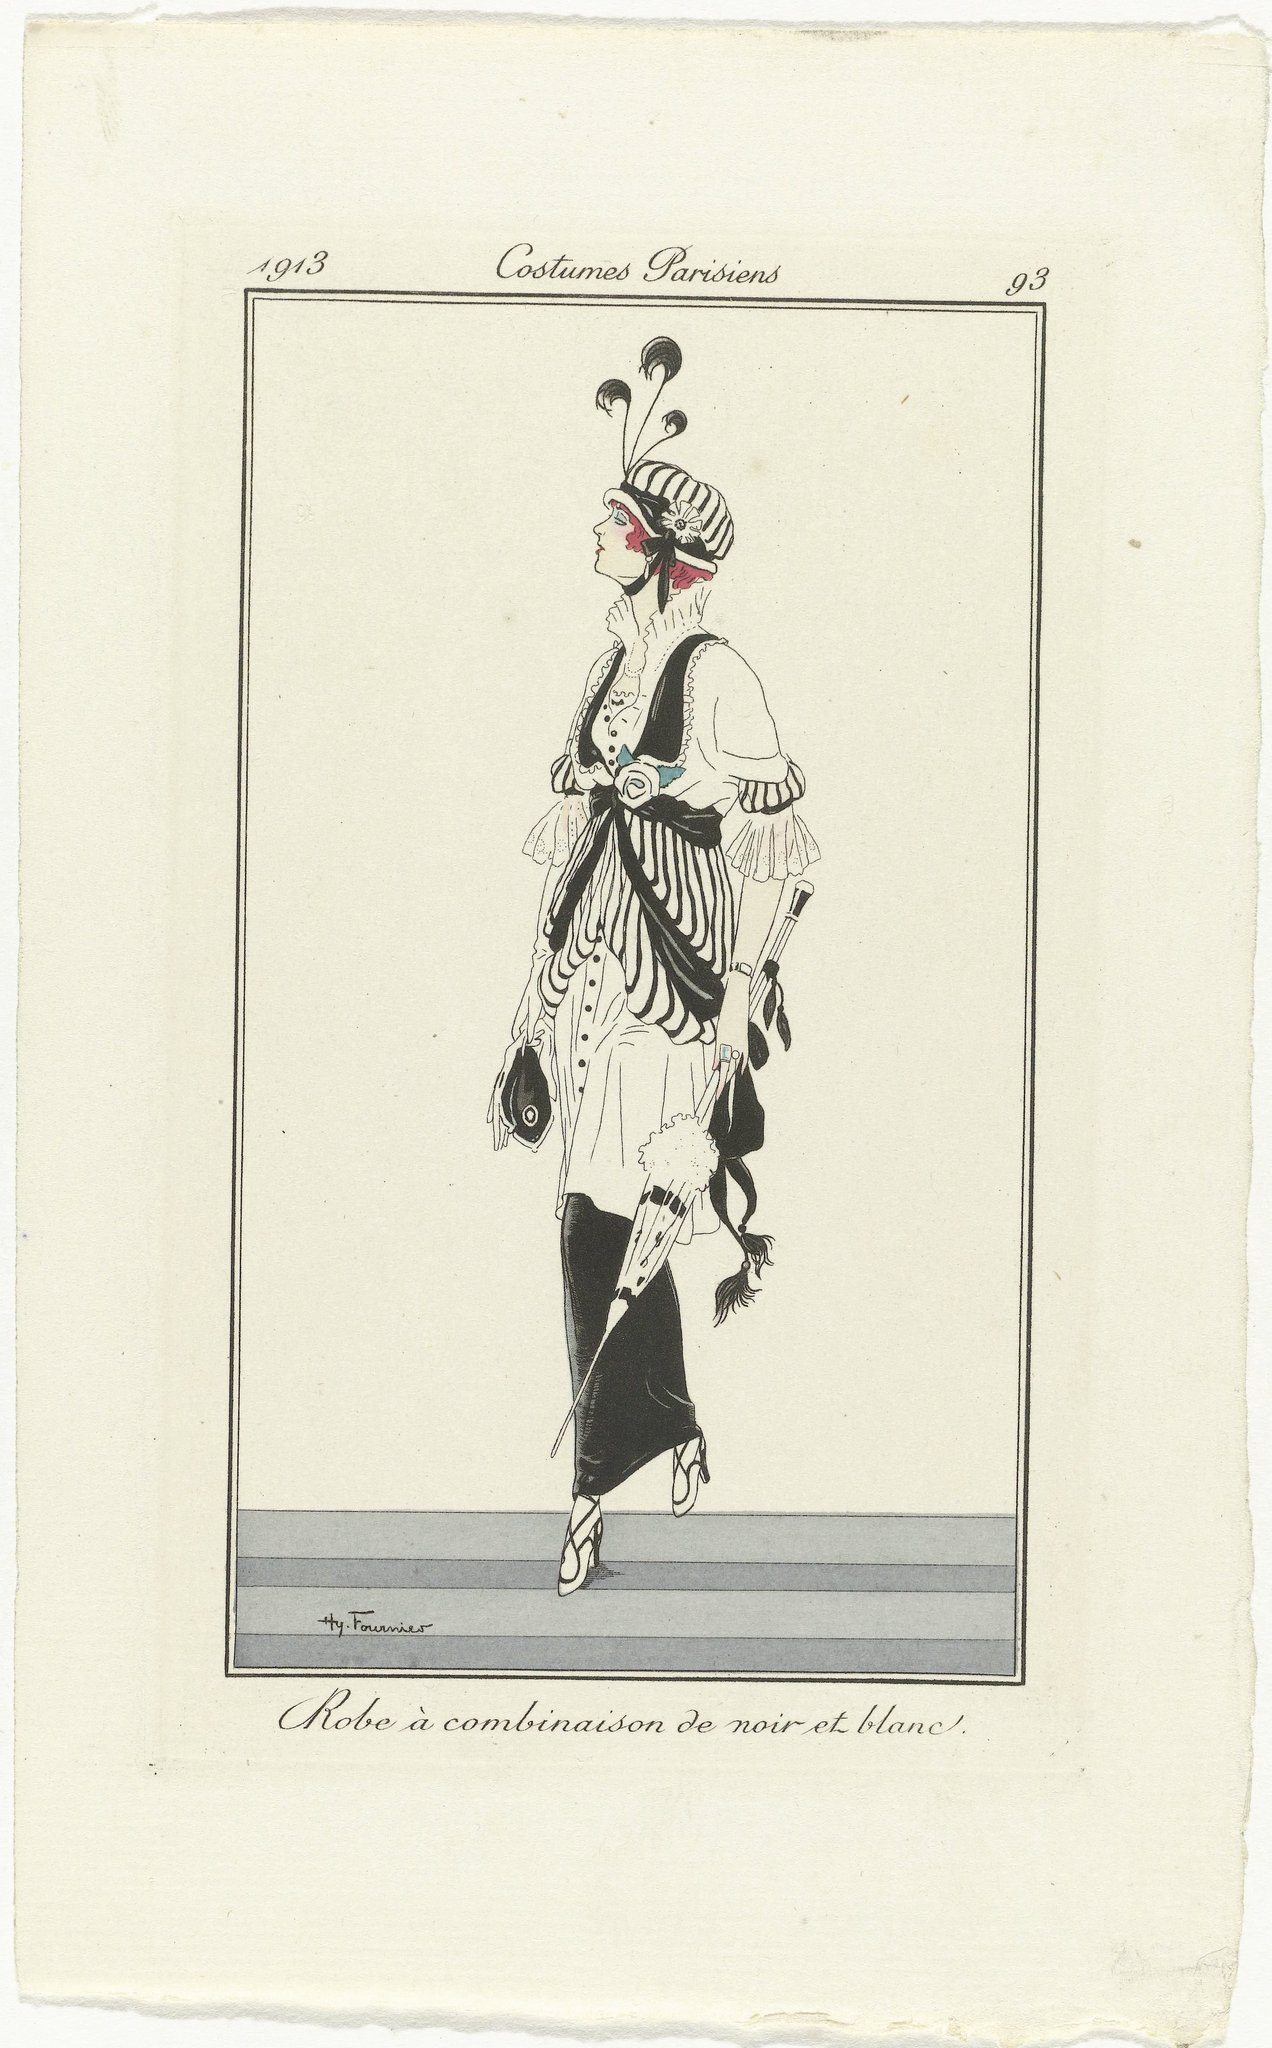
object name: fashion print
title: Journal des Dames et des Modes, Costumes Parisiens, 1913, No. 93 : Robe à combinaison (...)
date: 1913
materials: paper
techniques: engraving, hand coloring, pochoir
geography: paris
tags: bag (handbag) (+ women's clothes), fashion plates, head-gear: hat (+ women's clothes), gloves, mittens, etc. (+ women's clothes), dress, gown (+ women's clothes), parasol, sunshade (+ women's clothes)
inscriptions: title: ‘Costumes Parisiens’, caption: ‘Robe à combinaison de noir et blanc.’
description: Ensemble in zwart en wit, met bijpassende parasol. Prent uit het modetijdschrift Journal des Dames et des Modes (1912-1914).